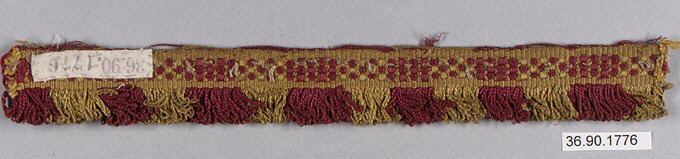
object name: fringe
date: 1801-1833